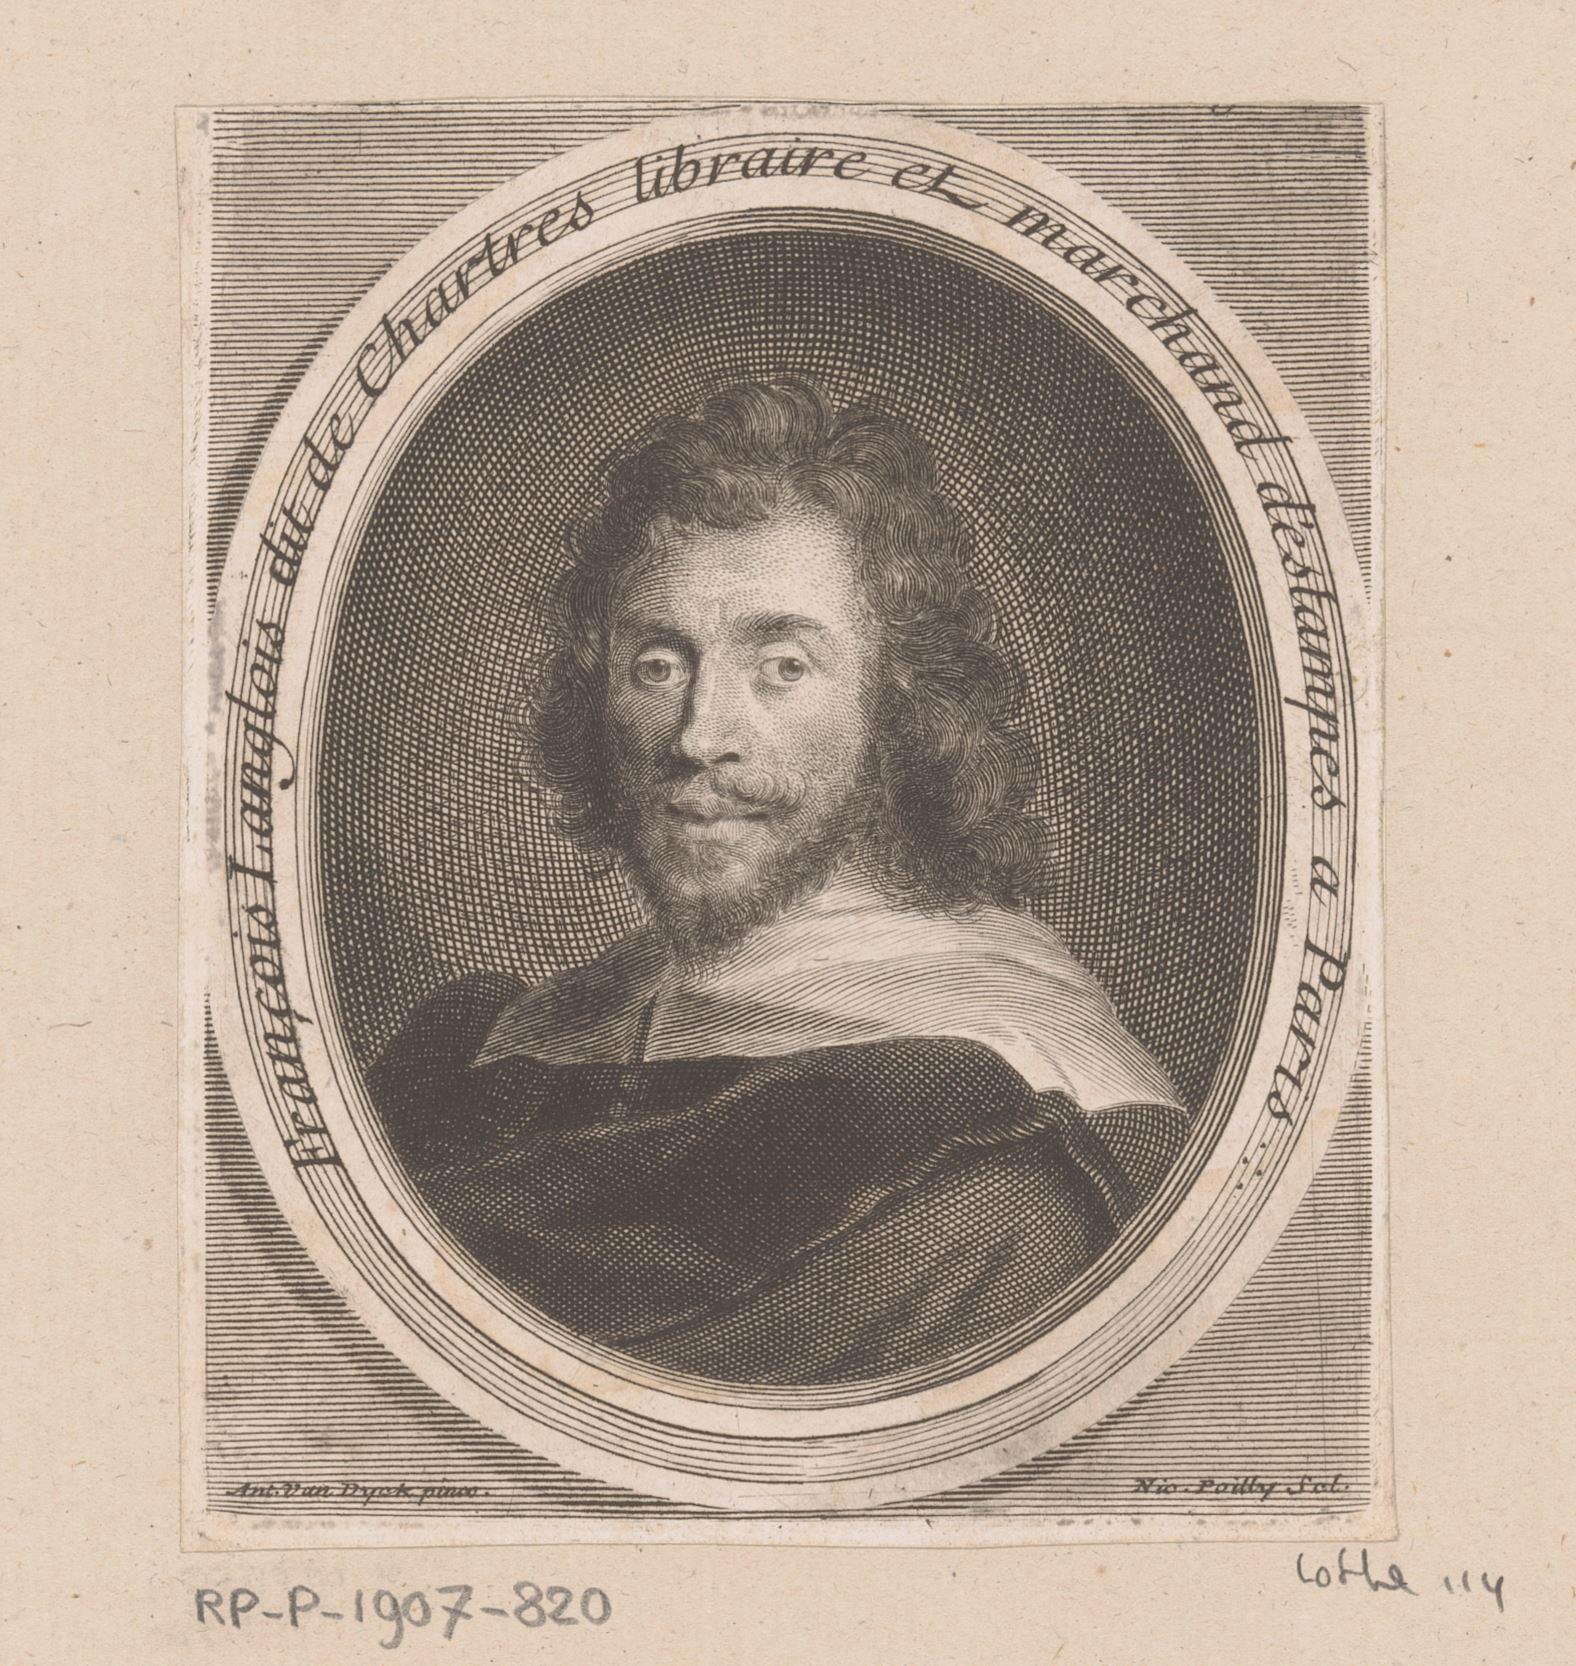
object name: print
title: Portret van François Langlois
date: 1636-1696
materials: paper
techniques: engraving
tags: paris, print maker, publisher, françois langlois, historical persons, publishing, publisher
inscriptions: collector's mark: Lugt 2228